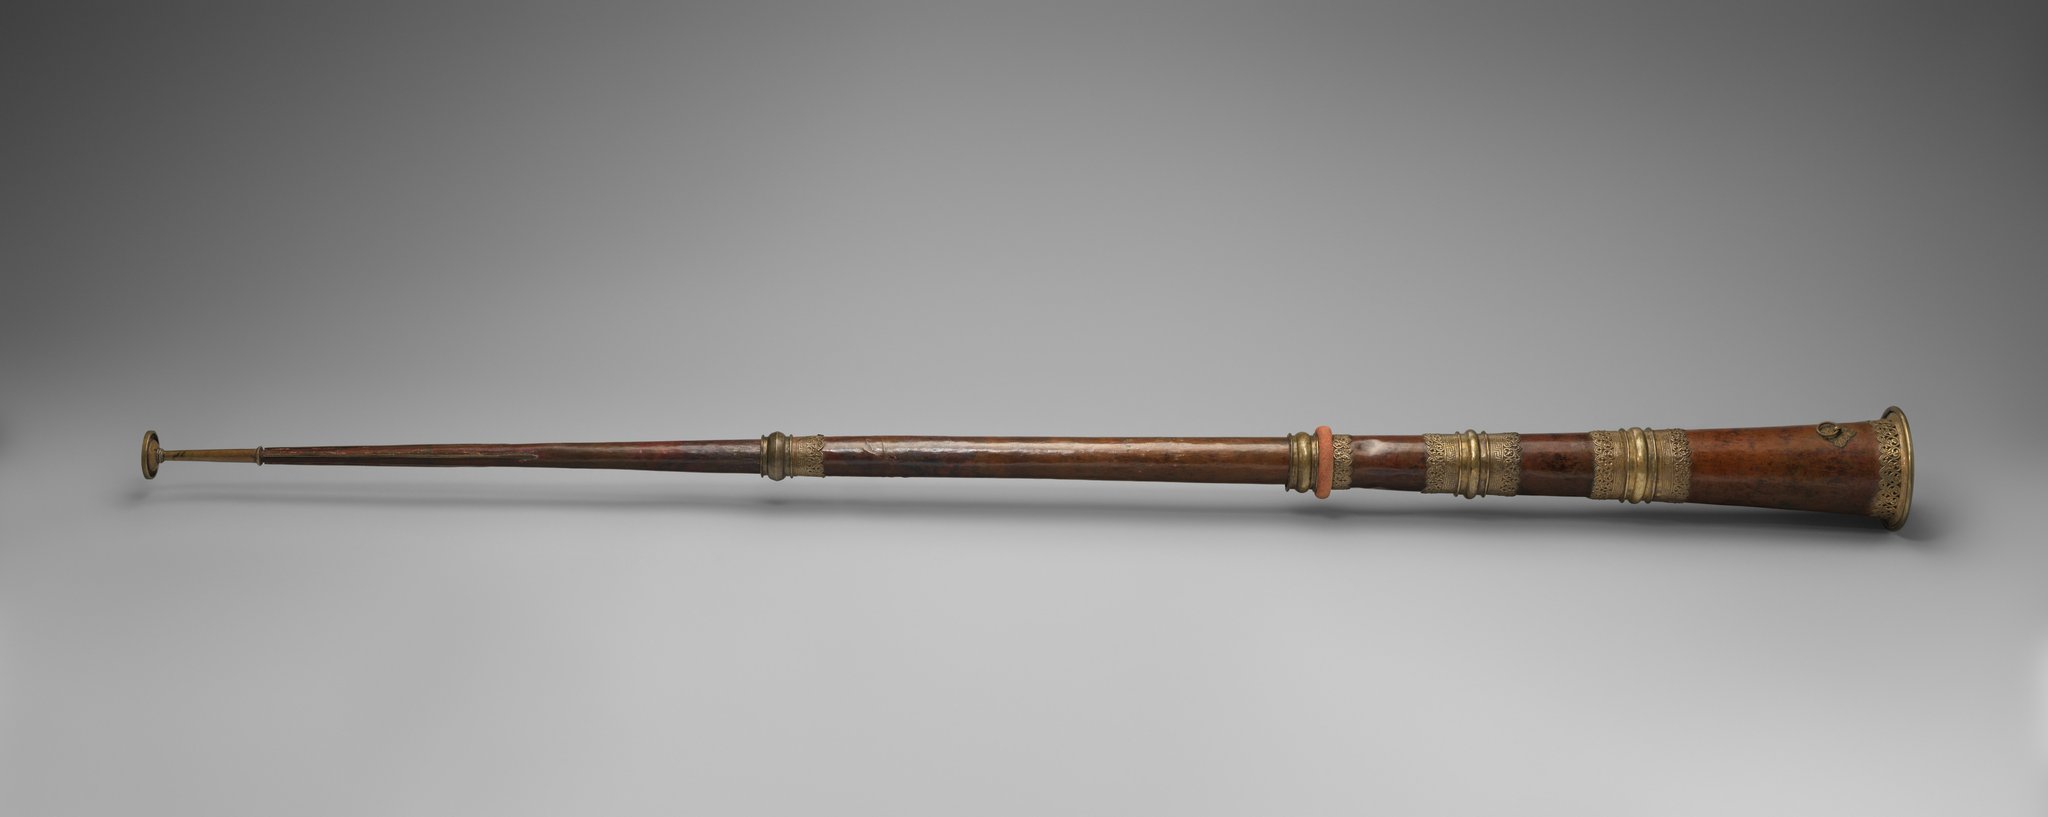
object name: dung chen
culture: tibetan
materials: metal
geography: tibet